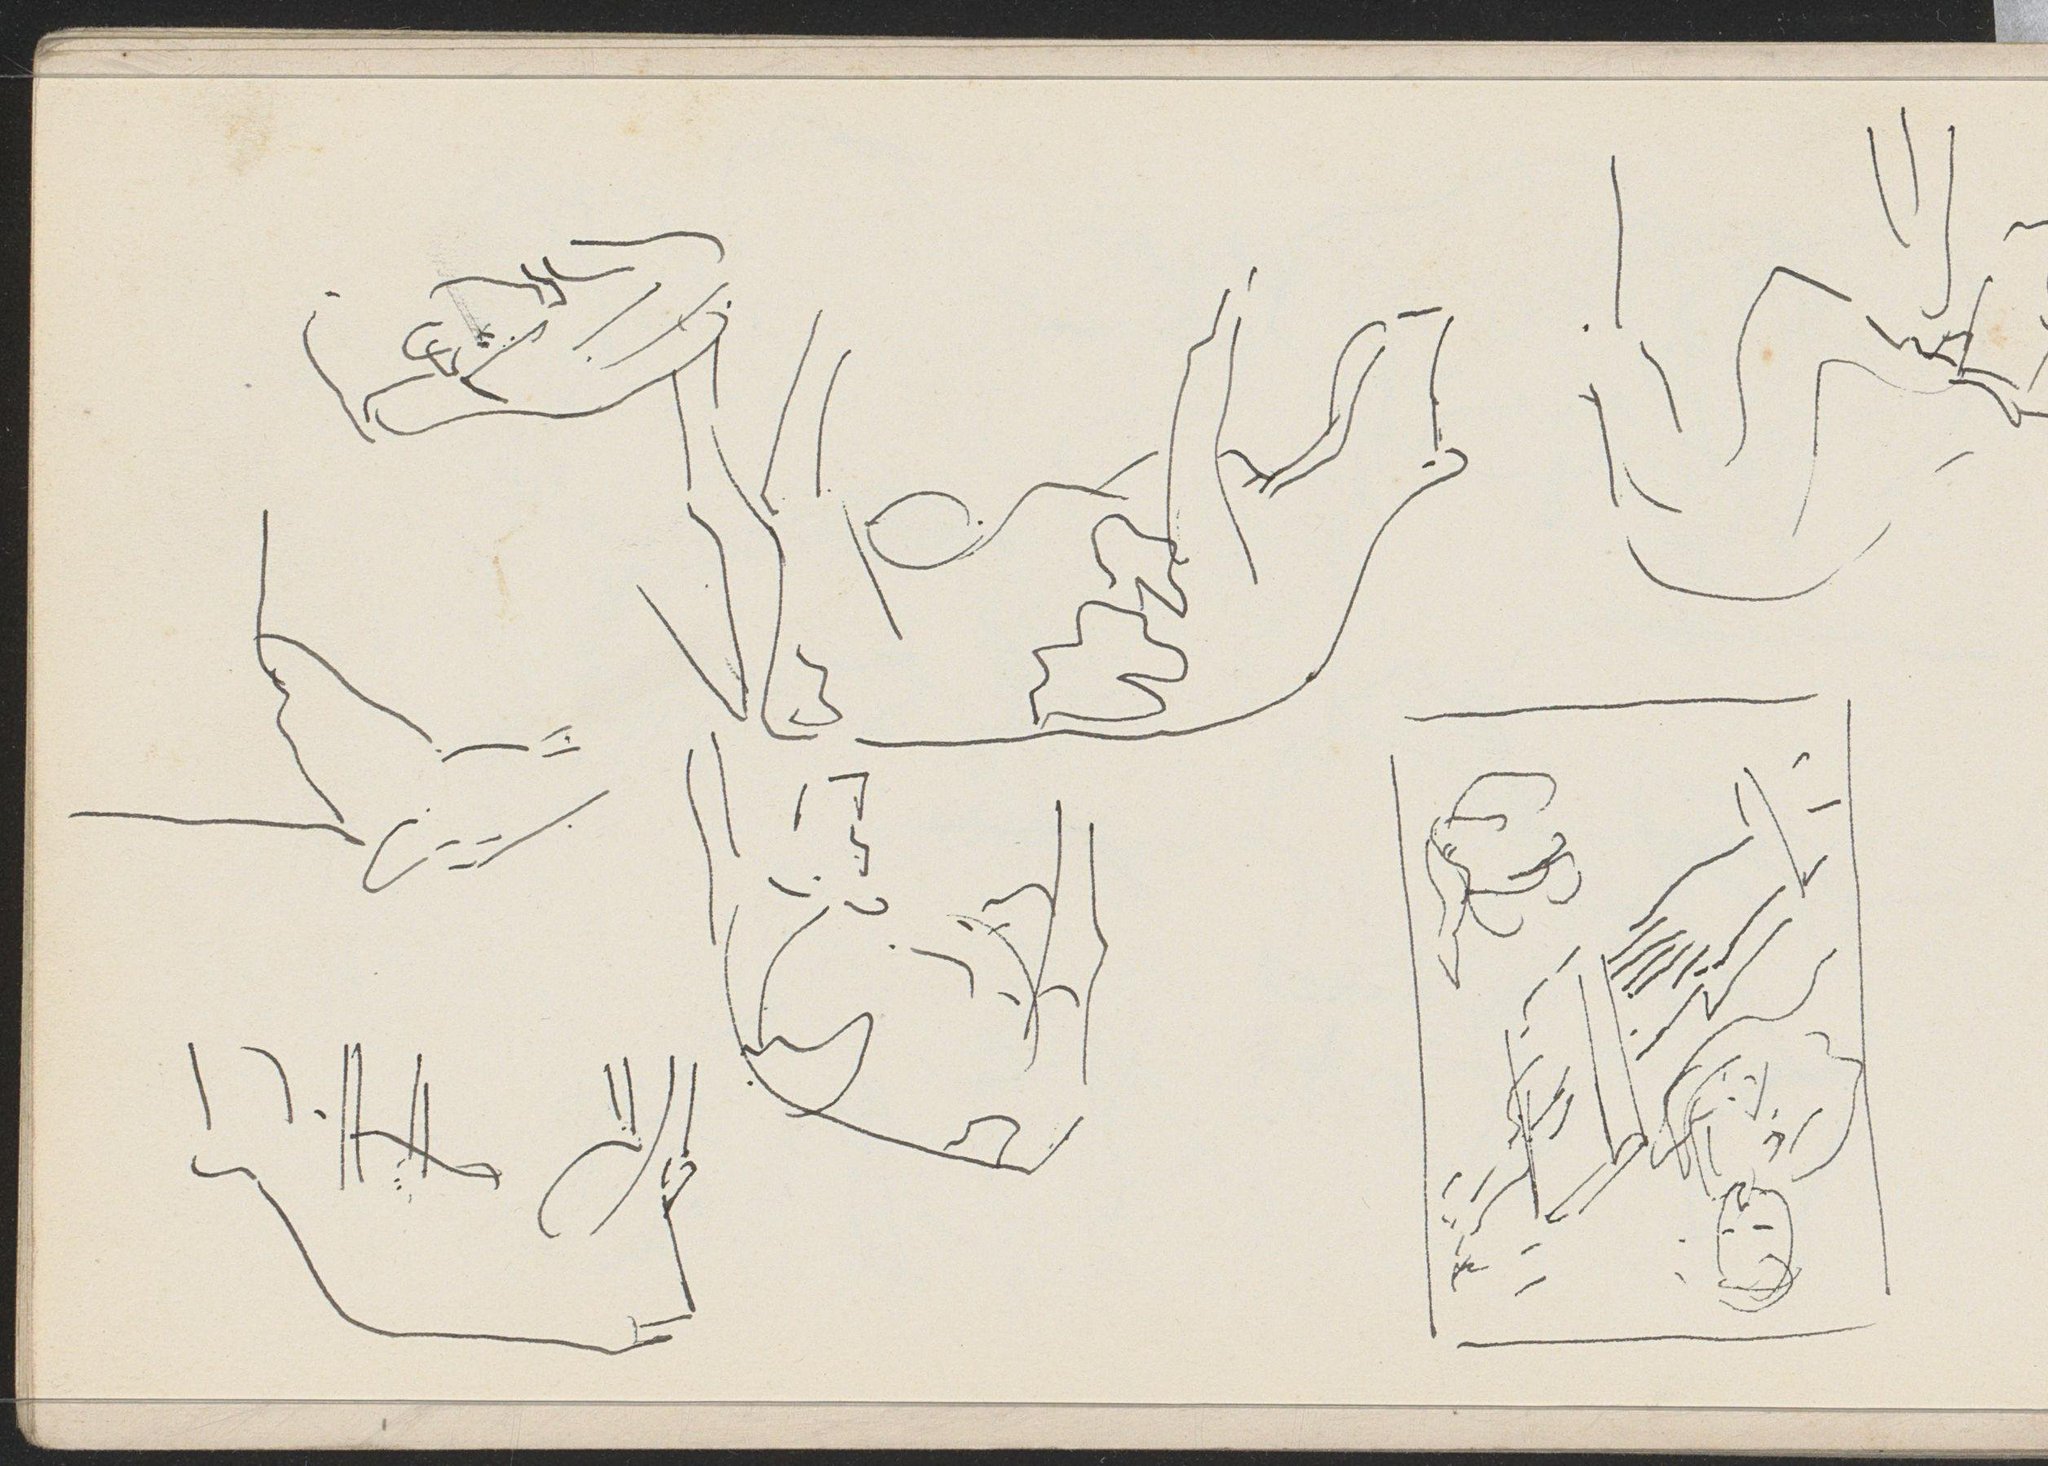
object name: sketchbook leaf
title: Studieblad met koeien, een hand en een figuur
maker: carel adolph lion cachet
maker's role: draughtsman, print maker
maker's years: 1864-1945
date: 1930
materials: ink, paper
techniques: pen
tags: cow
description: Blad 16 verso uit een schetsboek met 20 bladen.